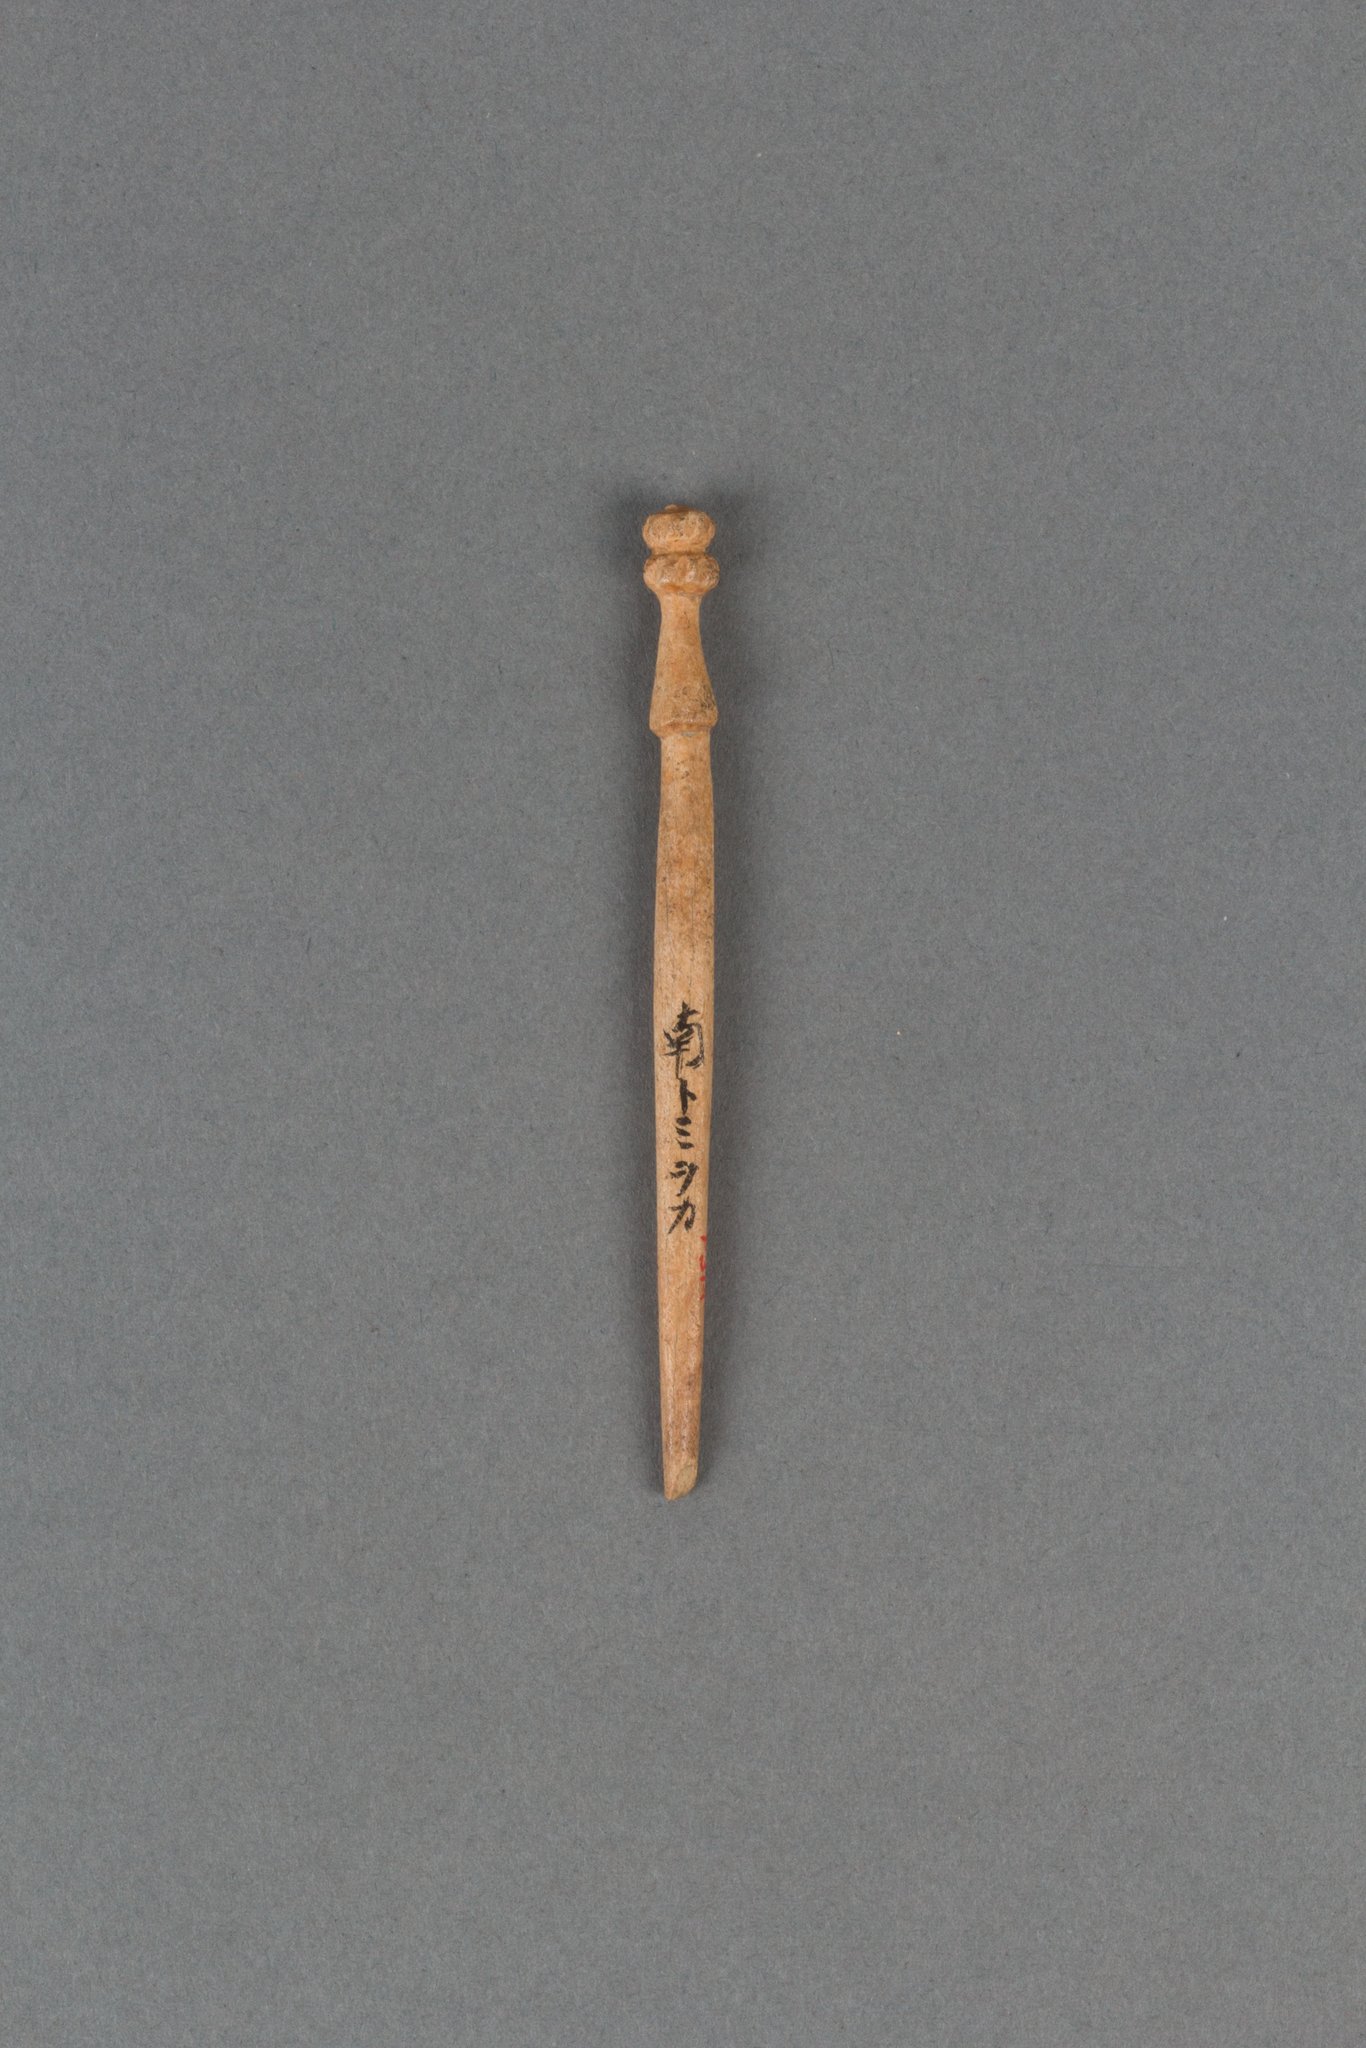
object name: hairpin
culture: japanese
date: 1200-200 BCE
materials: bone